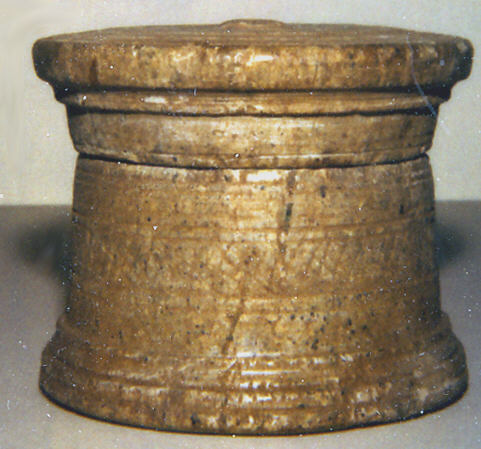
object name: reliquary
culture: gandhara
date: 1-300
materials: stone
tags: gandhara